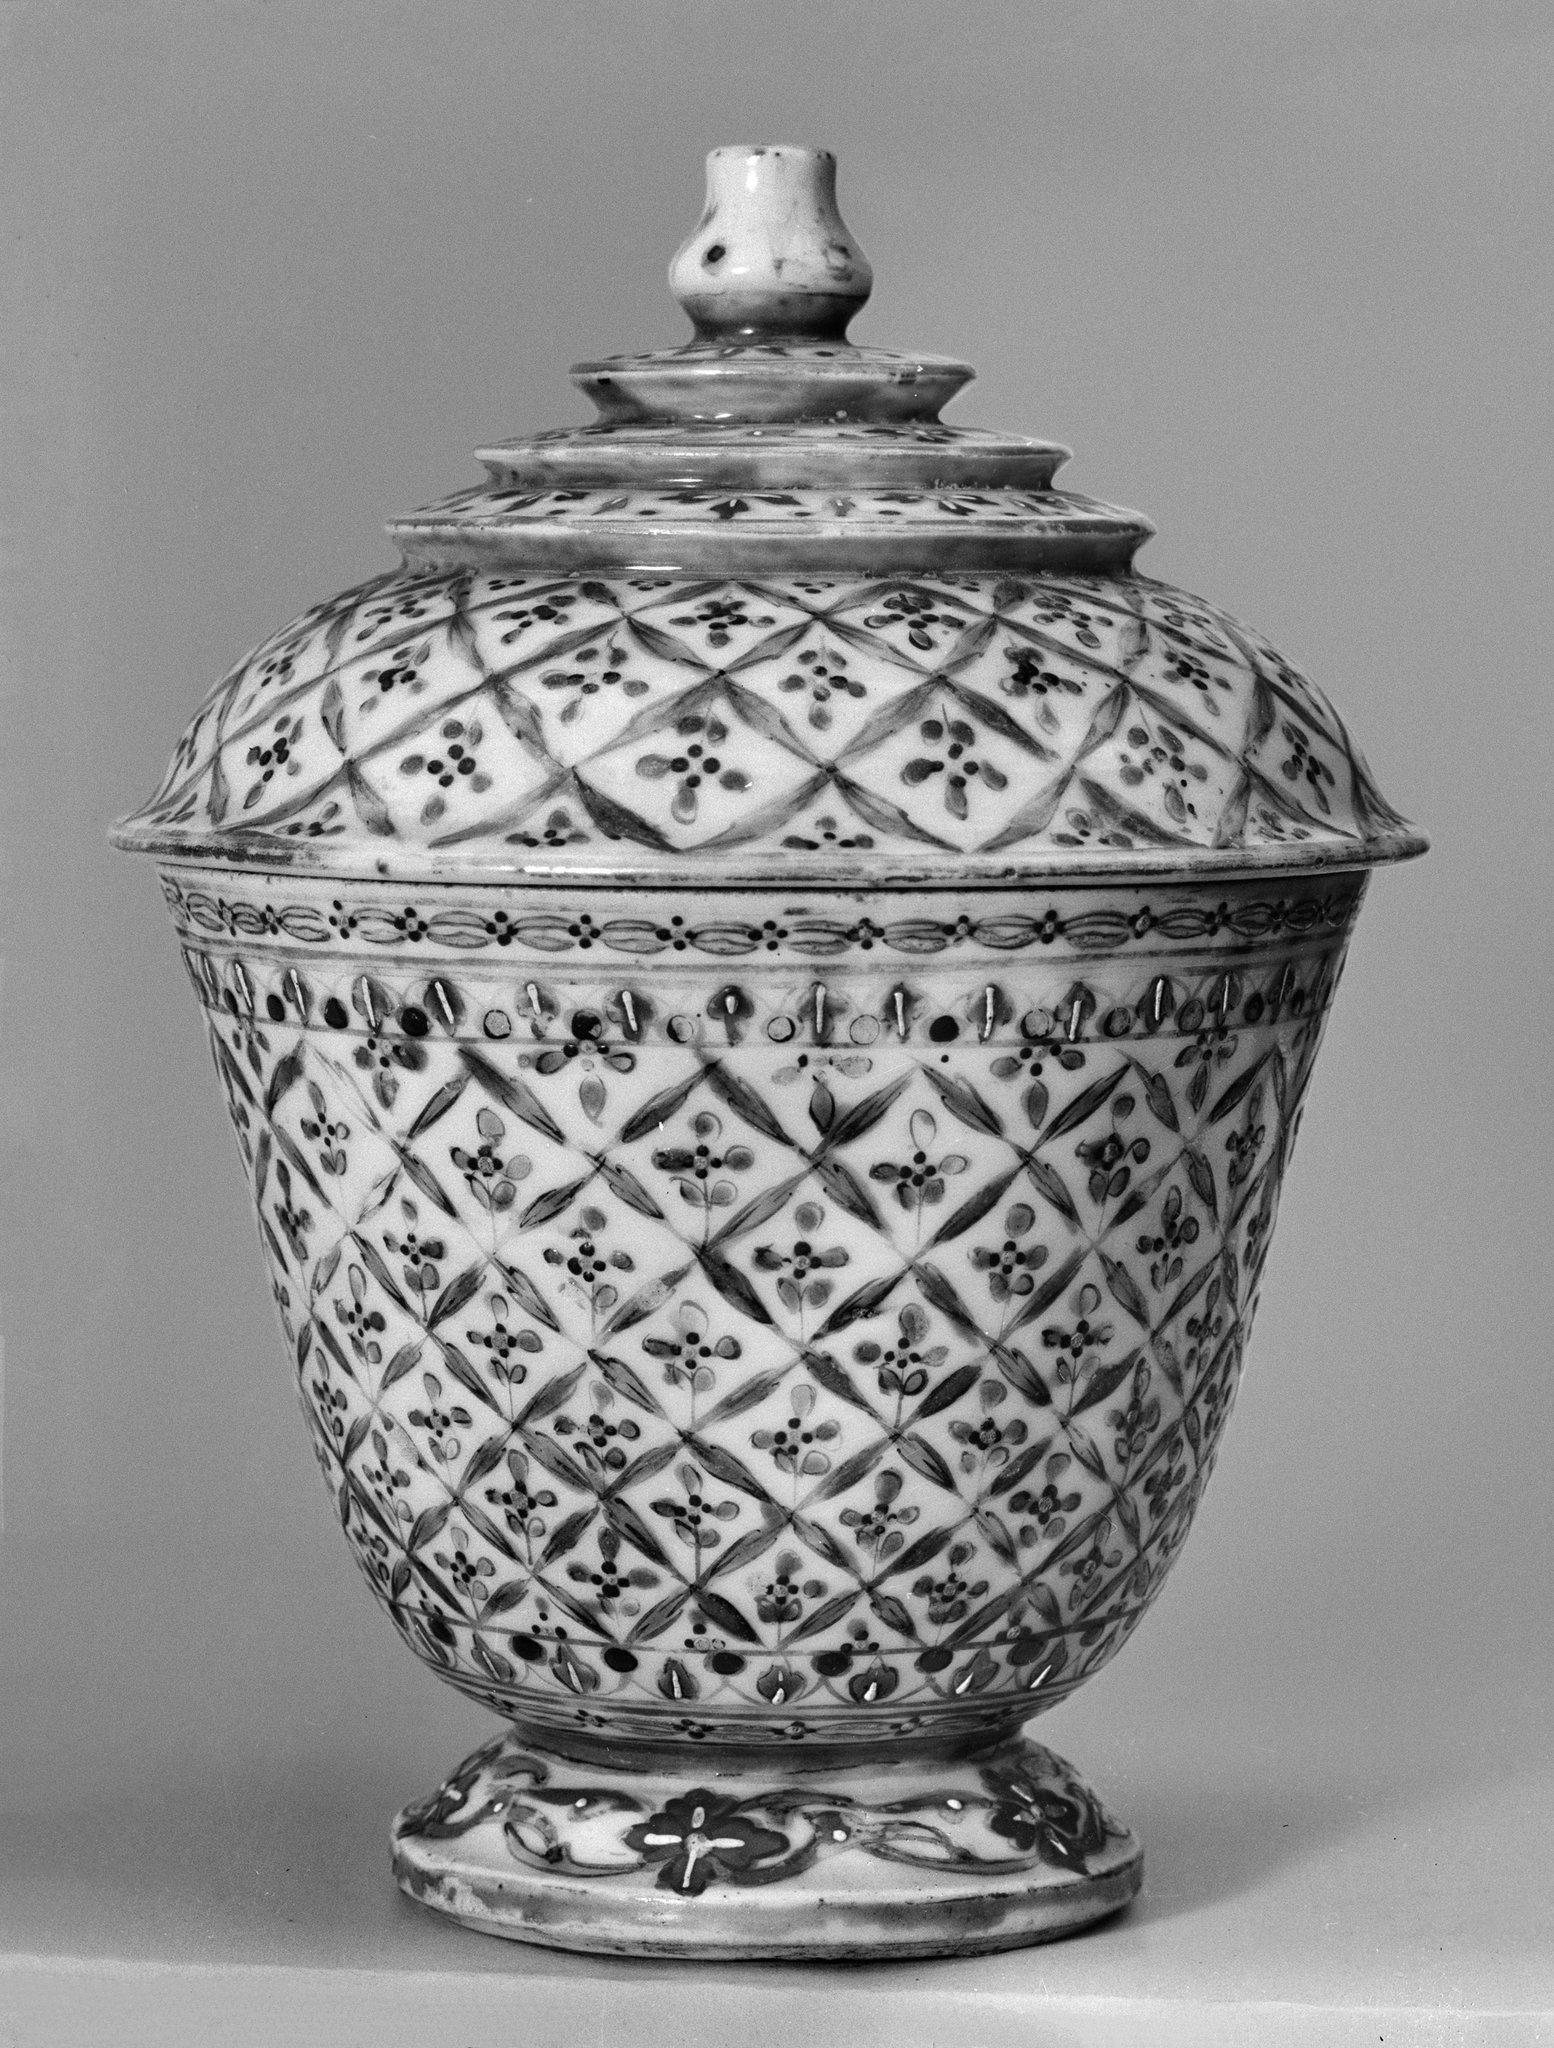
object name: covered cup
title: Covered cup with floral pattern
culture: chinese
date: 1801-1900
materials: enamel, porcelain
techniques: overglaze, painting, polychrome